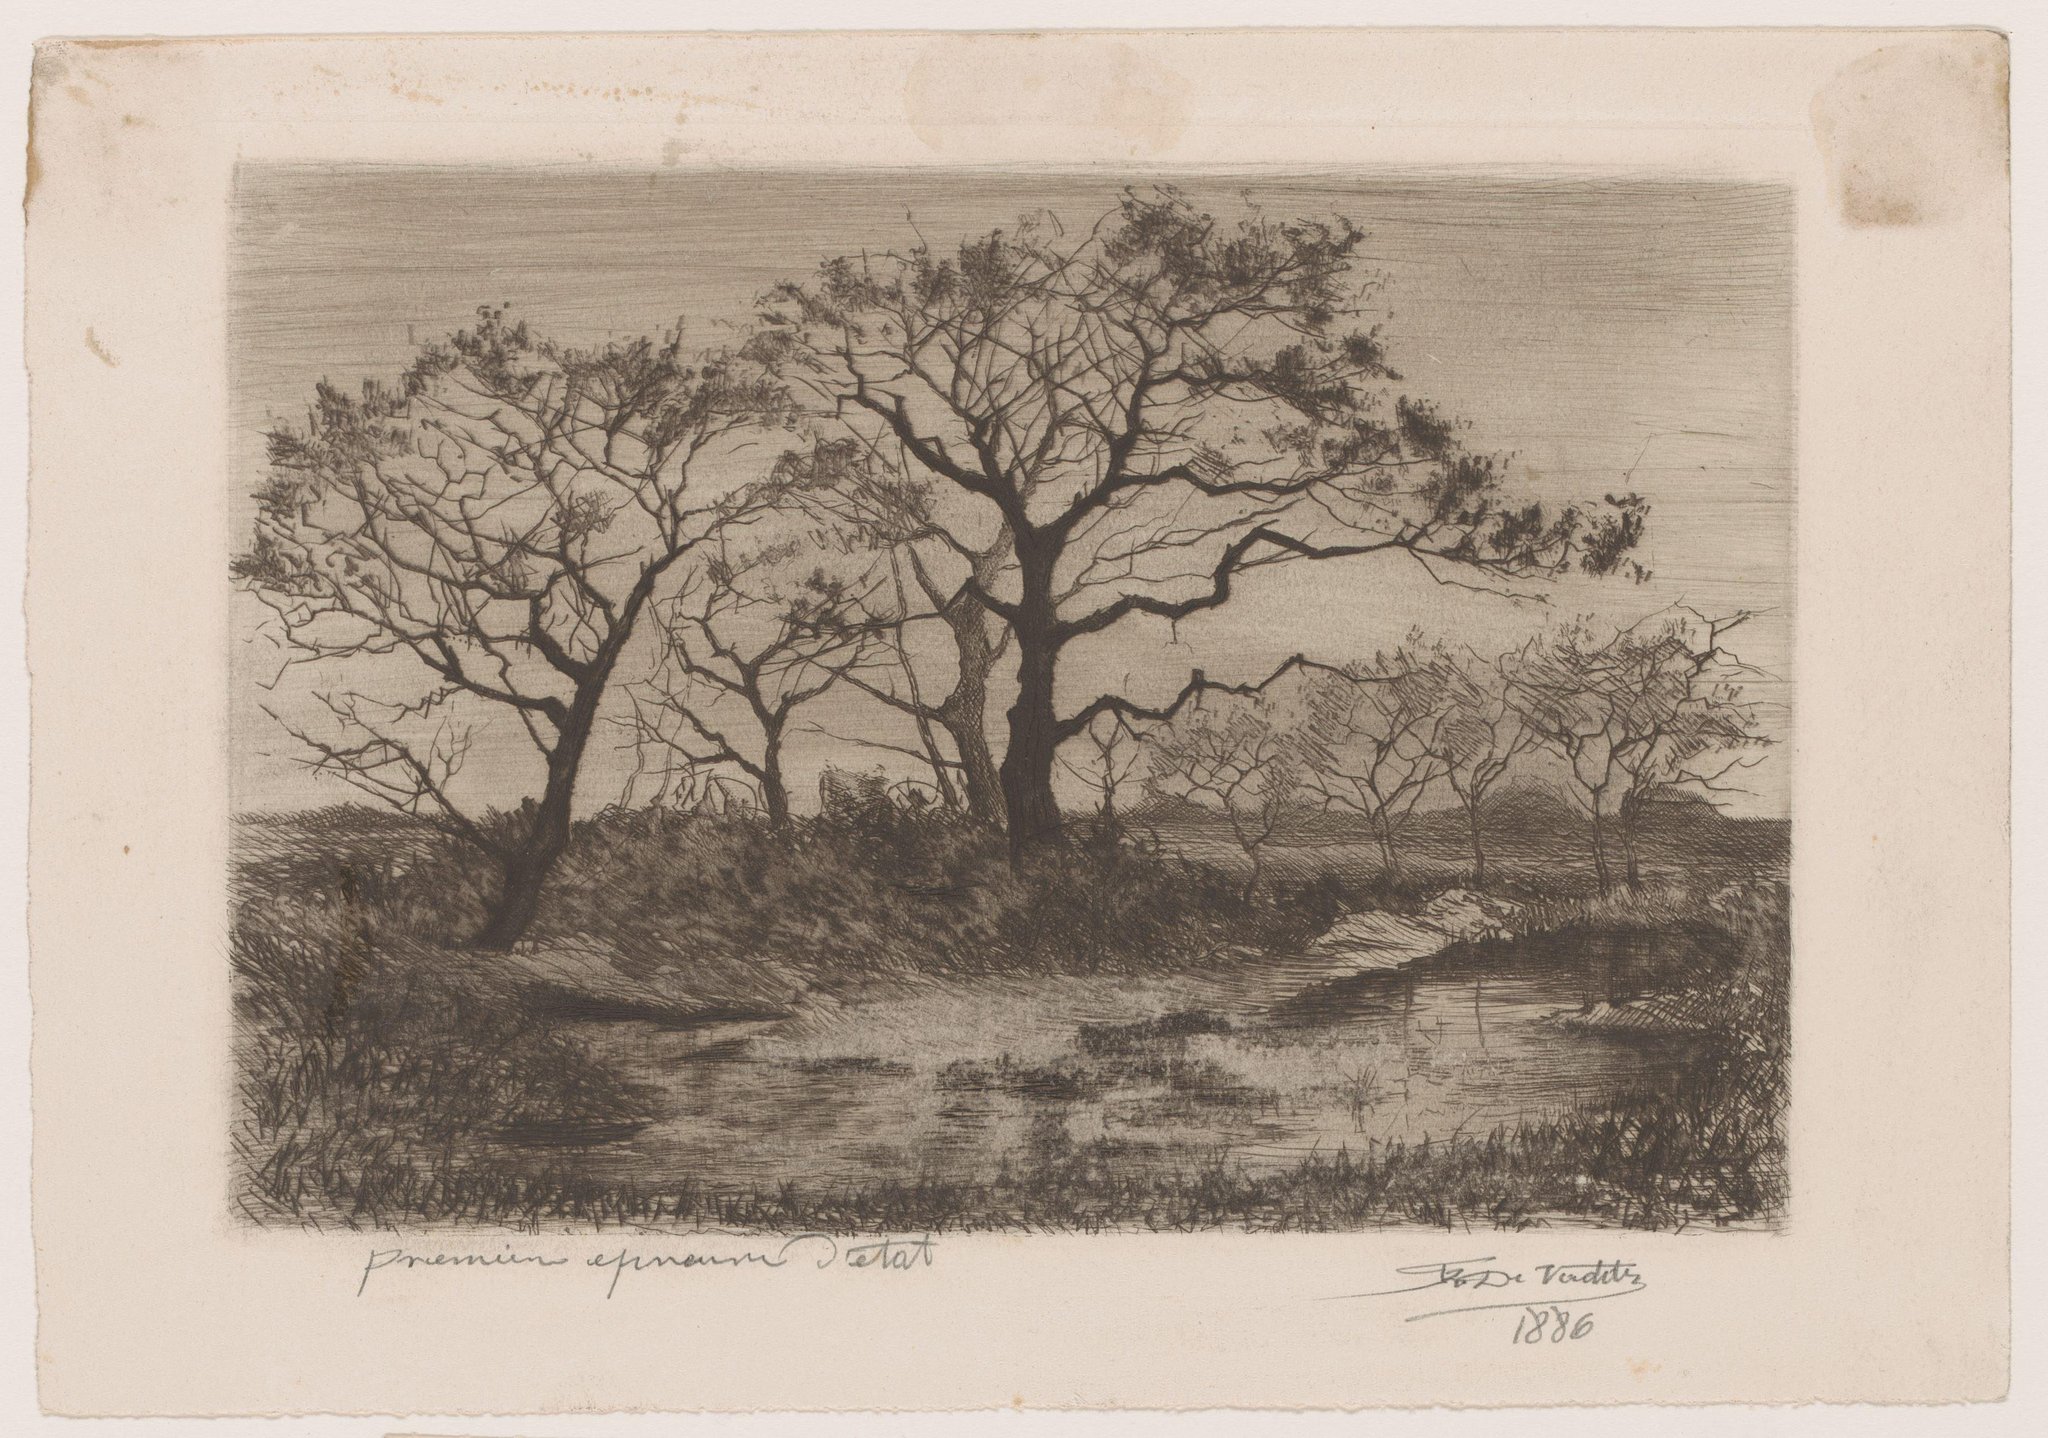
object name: print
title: Bomen aan een waterplas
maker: frans de vadder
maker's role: print maker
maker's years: 1862-1936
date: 1886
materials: paper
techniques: etching, intaglio, retroussage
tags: water course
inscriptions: inscription: ‘Premier epreuve d etat; 1886’, collector's mark: Lugt 2228